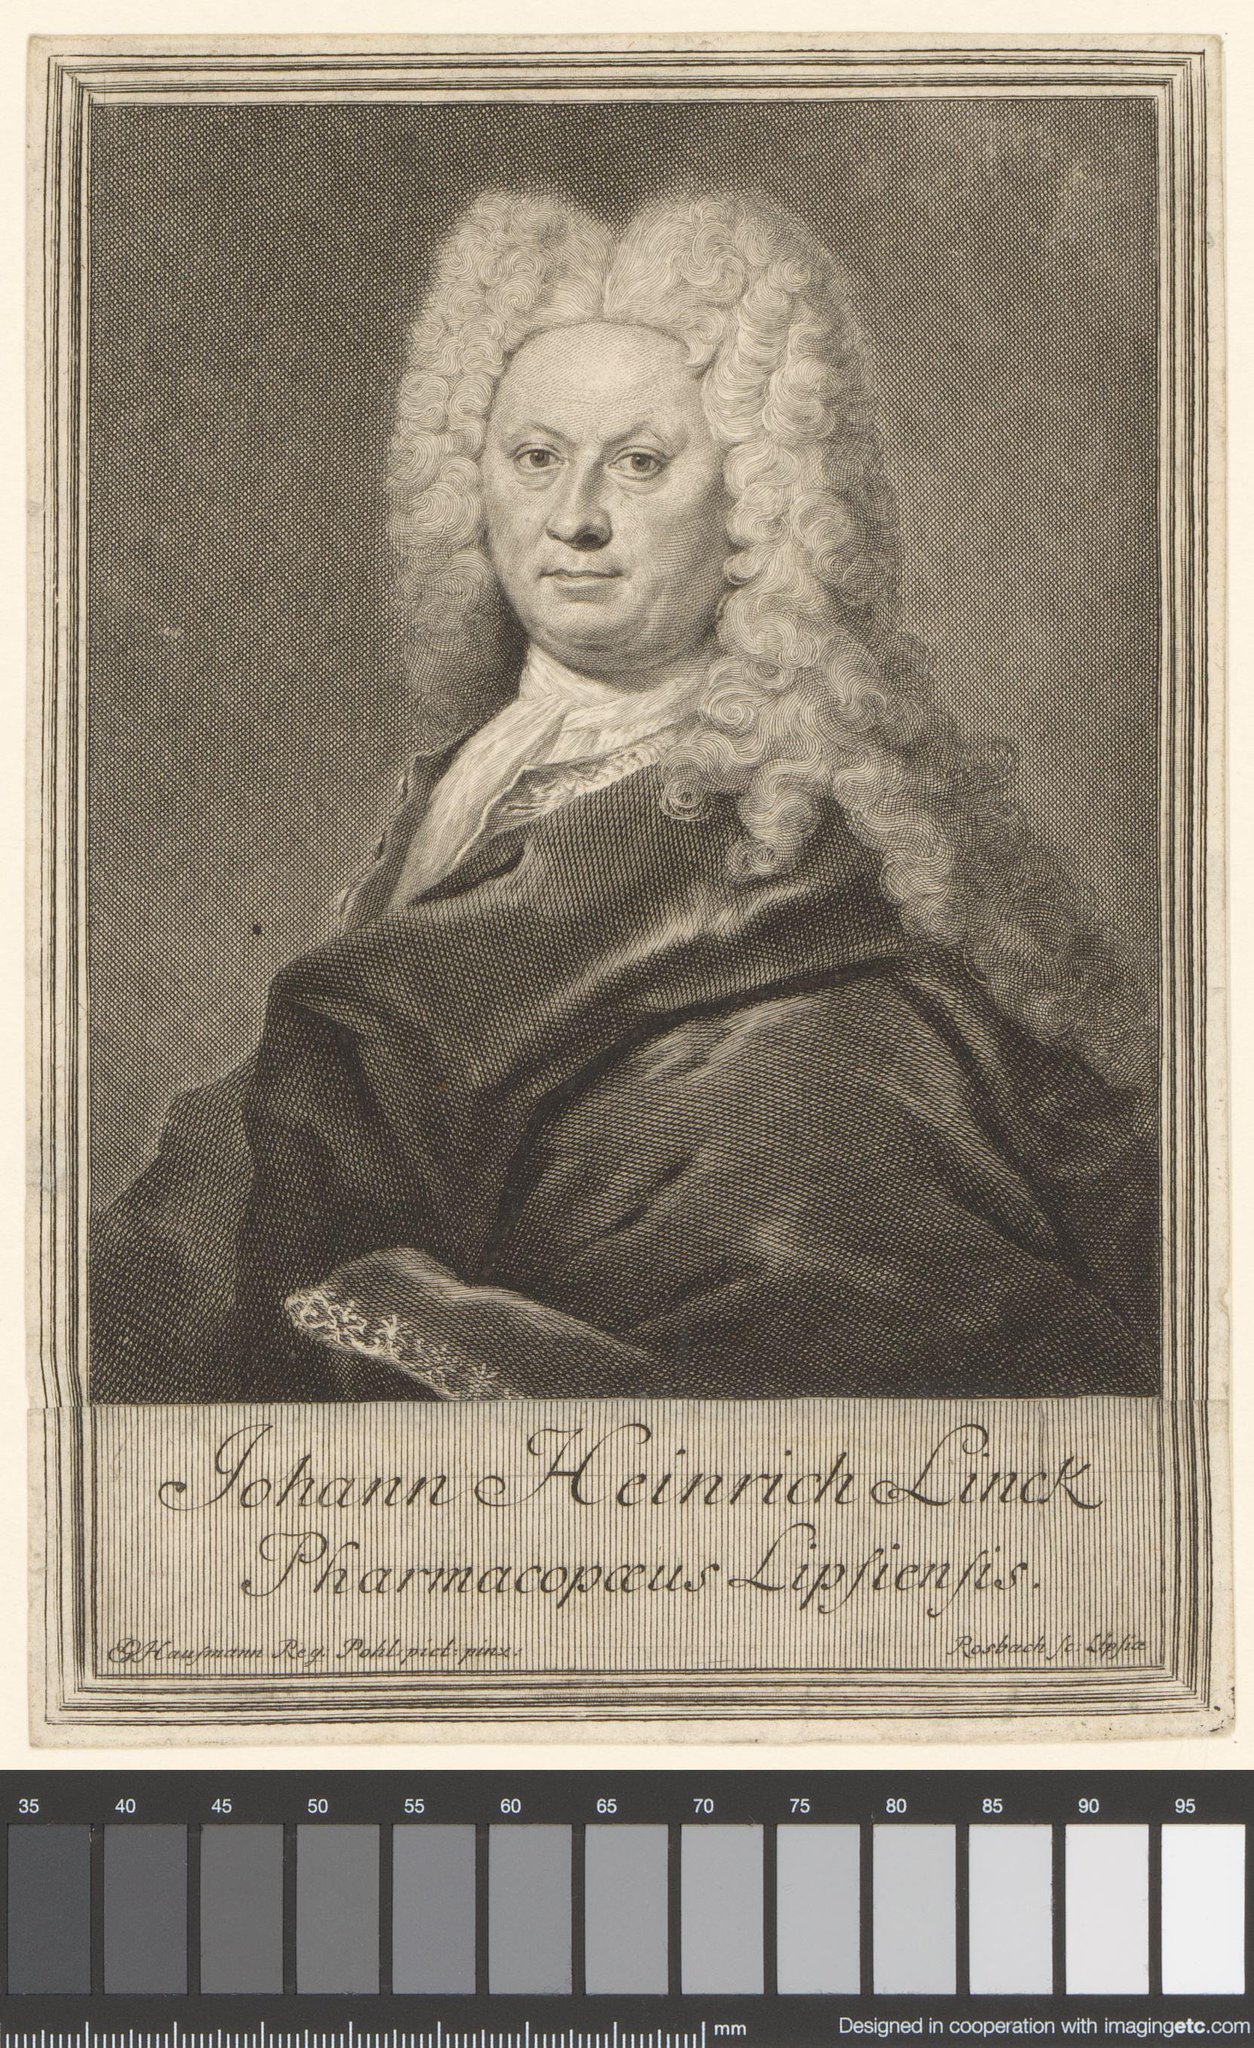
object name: print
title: Portret van Johann Heinrich Linck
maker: johann friedrich rosbach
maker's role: print maker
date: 1700-1749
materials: paper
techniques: engraving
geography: leipzig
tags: historical persons, wig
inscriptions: collector's mark: Lugt 2228